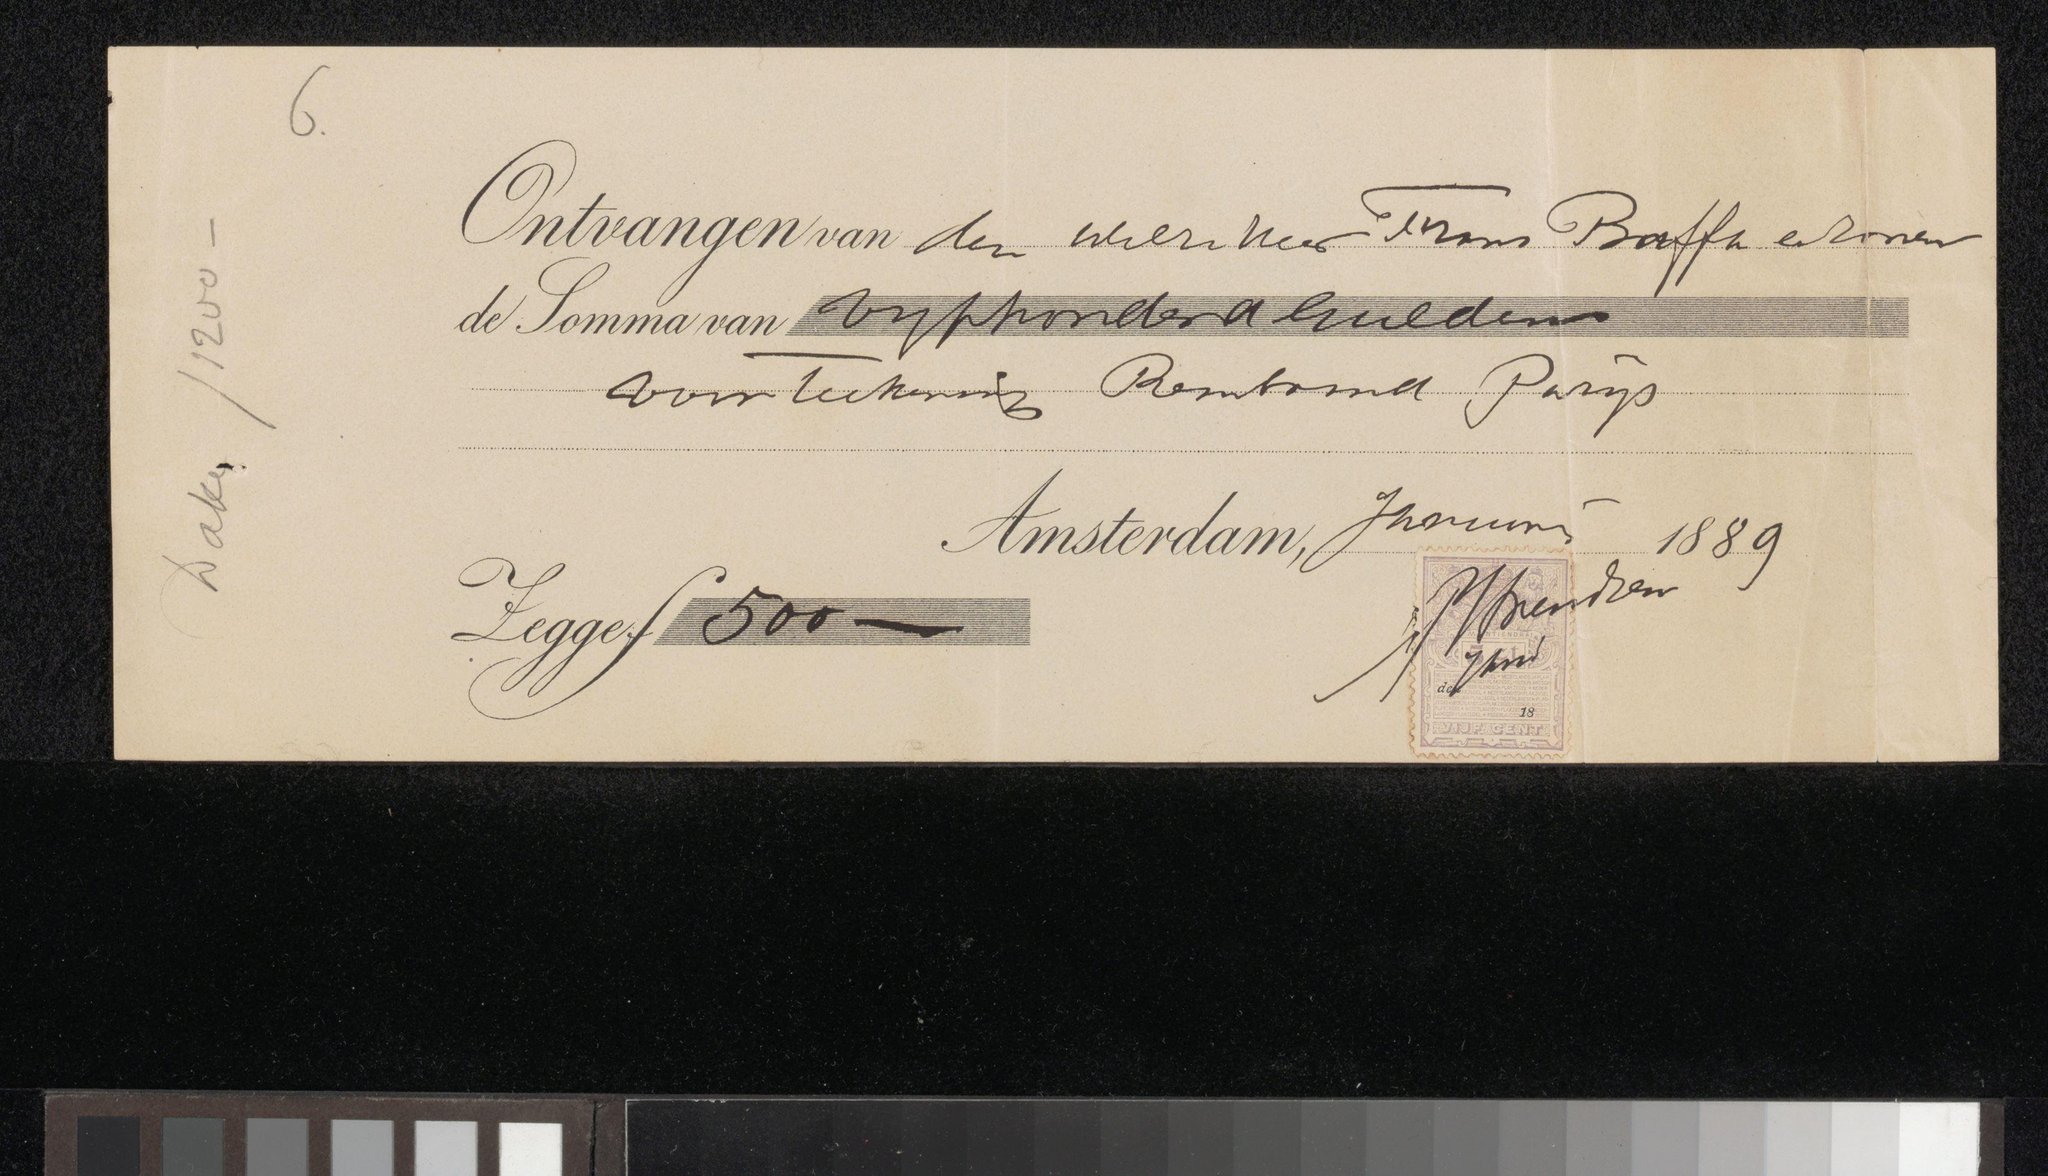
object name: ontvangstbewijs, kwitantie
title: Kwitantie aan Petrus Johannes Arendzen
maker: petrus johannes arendzen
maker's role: draughtsman, print maker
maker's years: 1846-1932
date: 1801-1889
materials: ink, paper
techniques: pen, printing, writing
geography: amsterdam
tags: leiden, amsterdam, painter, print maker, draughtsman, rembrandt van rijn, drawing, money, paris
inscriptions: collector's mark: Lugt 2233